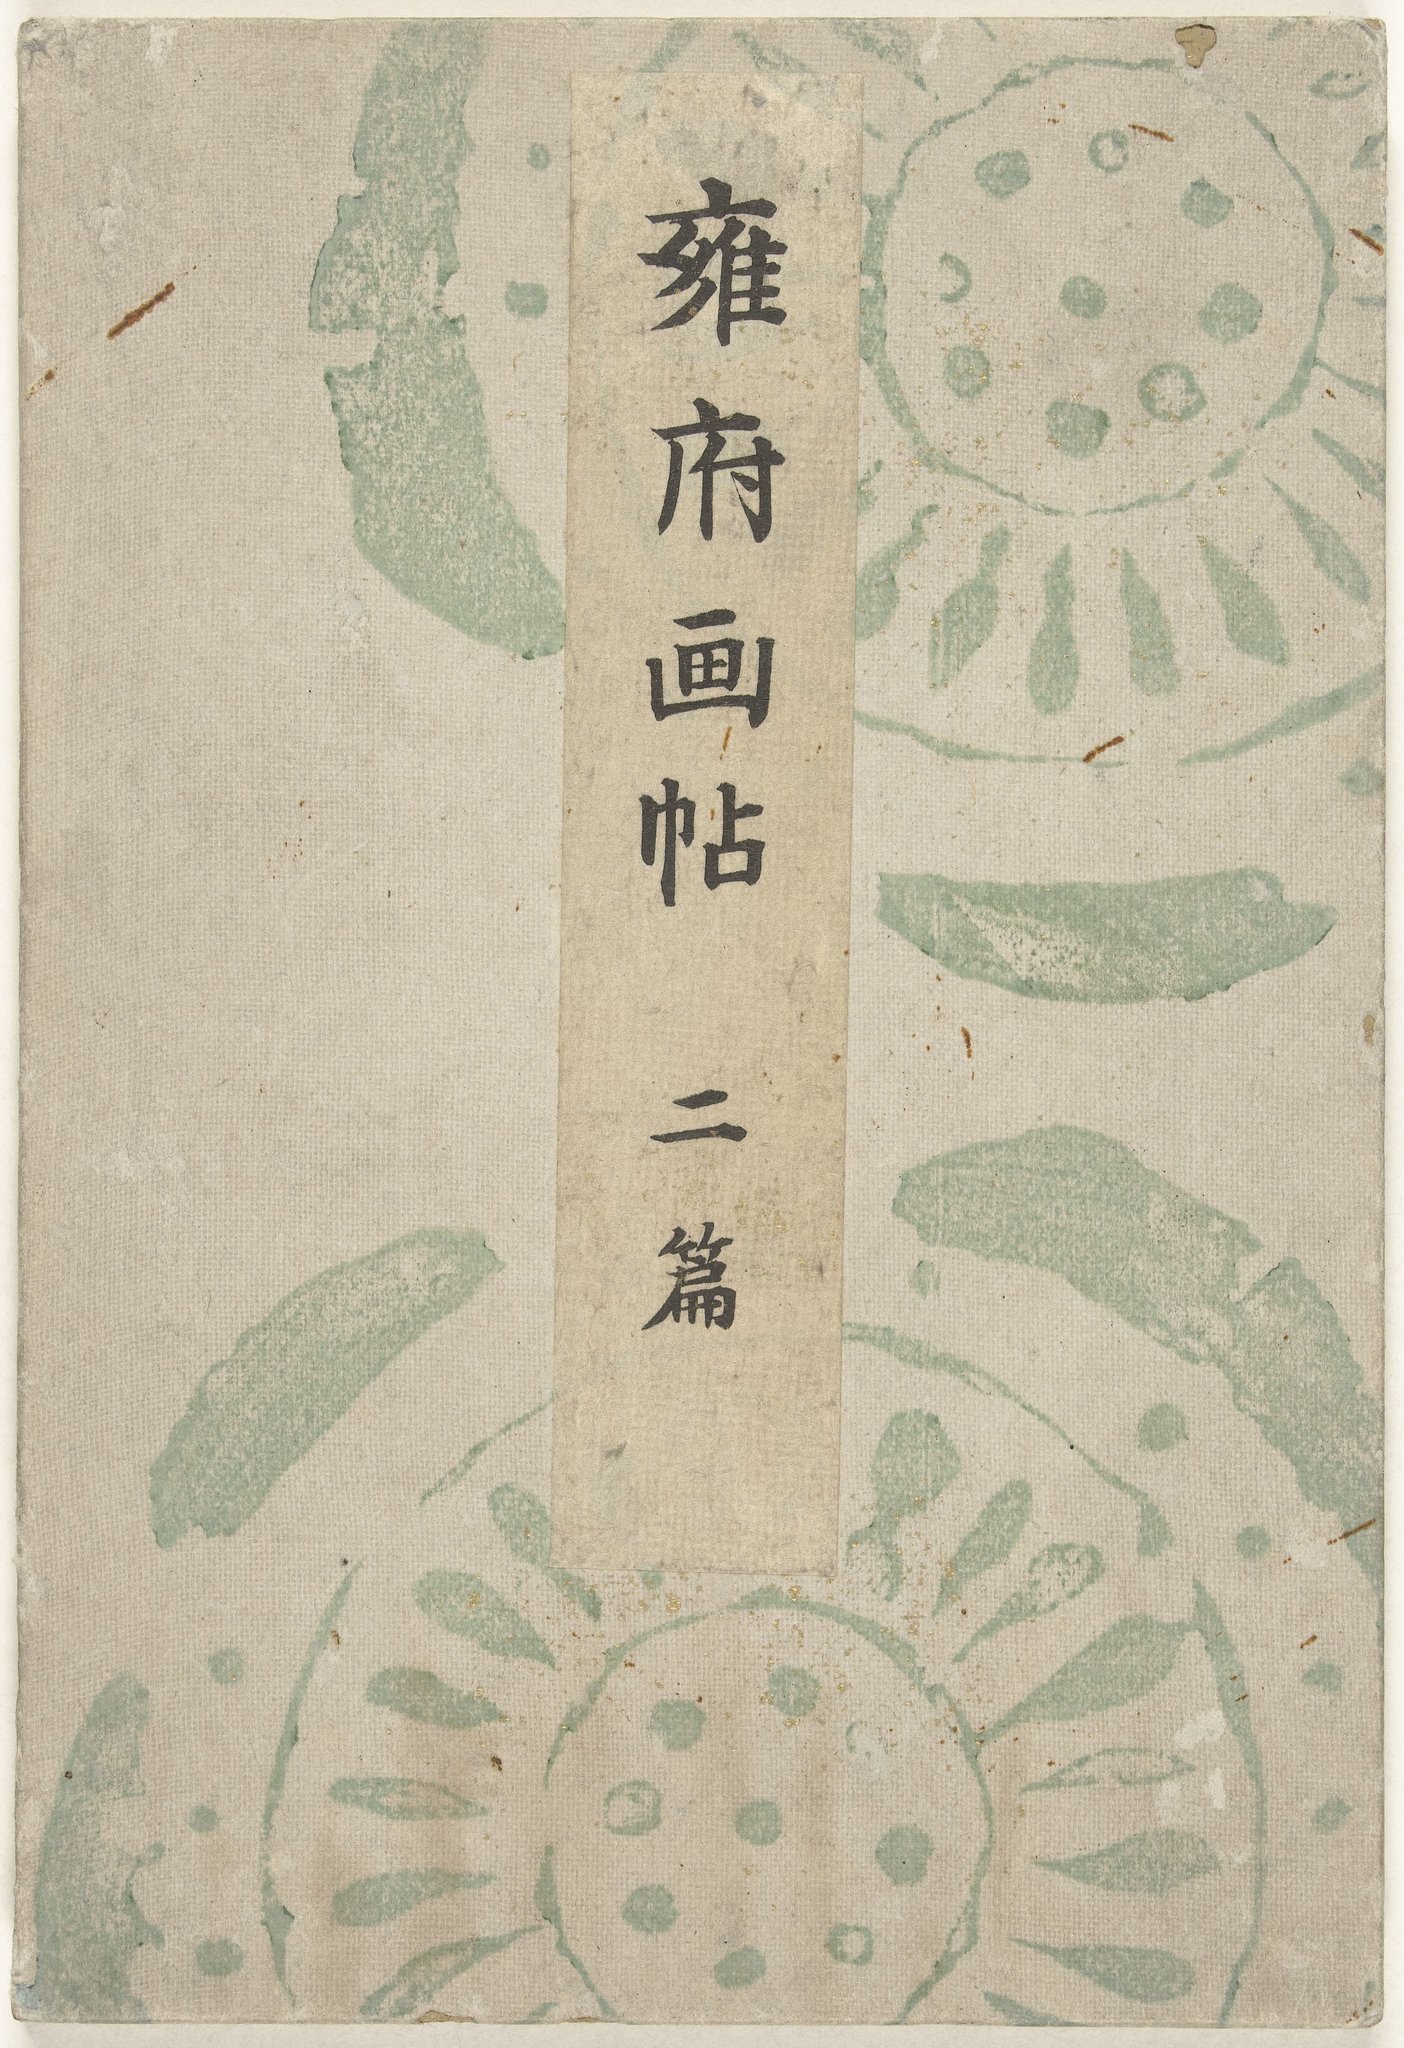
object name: book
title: Kyoto prentenboek - deel twee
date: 1897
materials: paper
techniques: woodcut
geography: kyoto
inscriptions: collector's mark: Lugt 2228